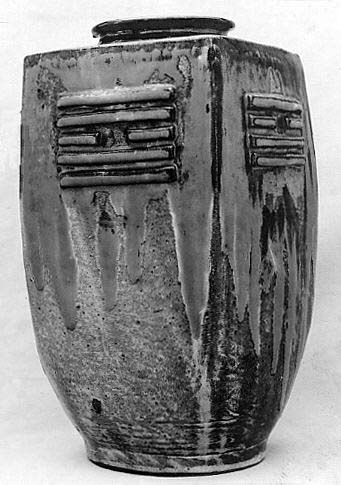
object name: jar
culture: japanese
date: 1801-1900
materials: glaze, paste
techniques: overglaze